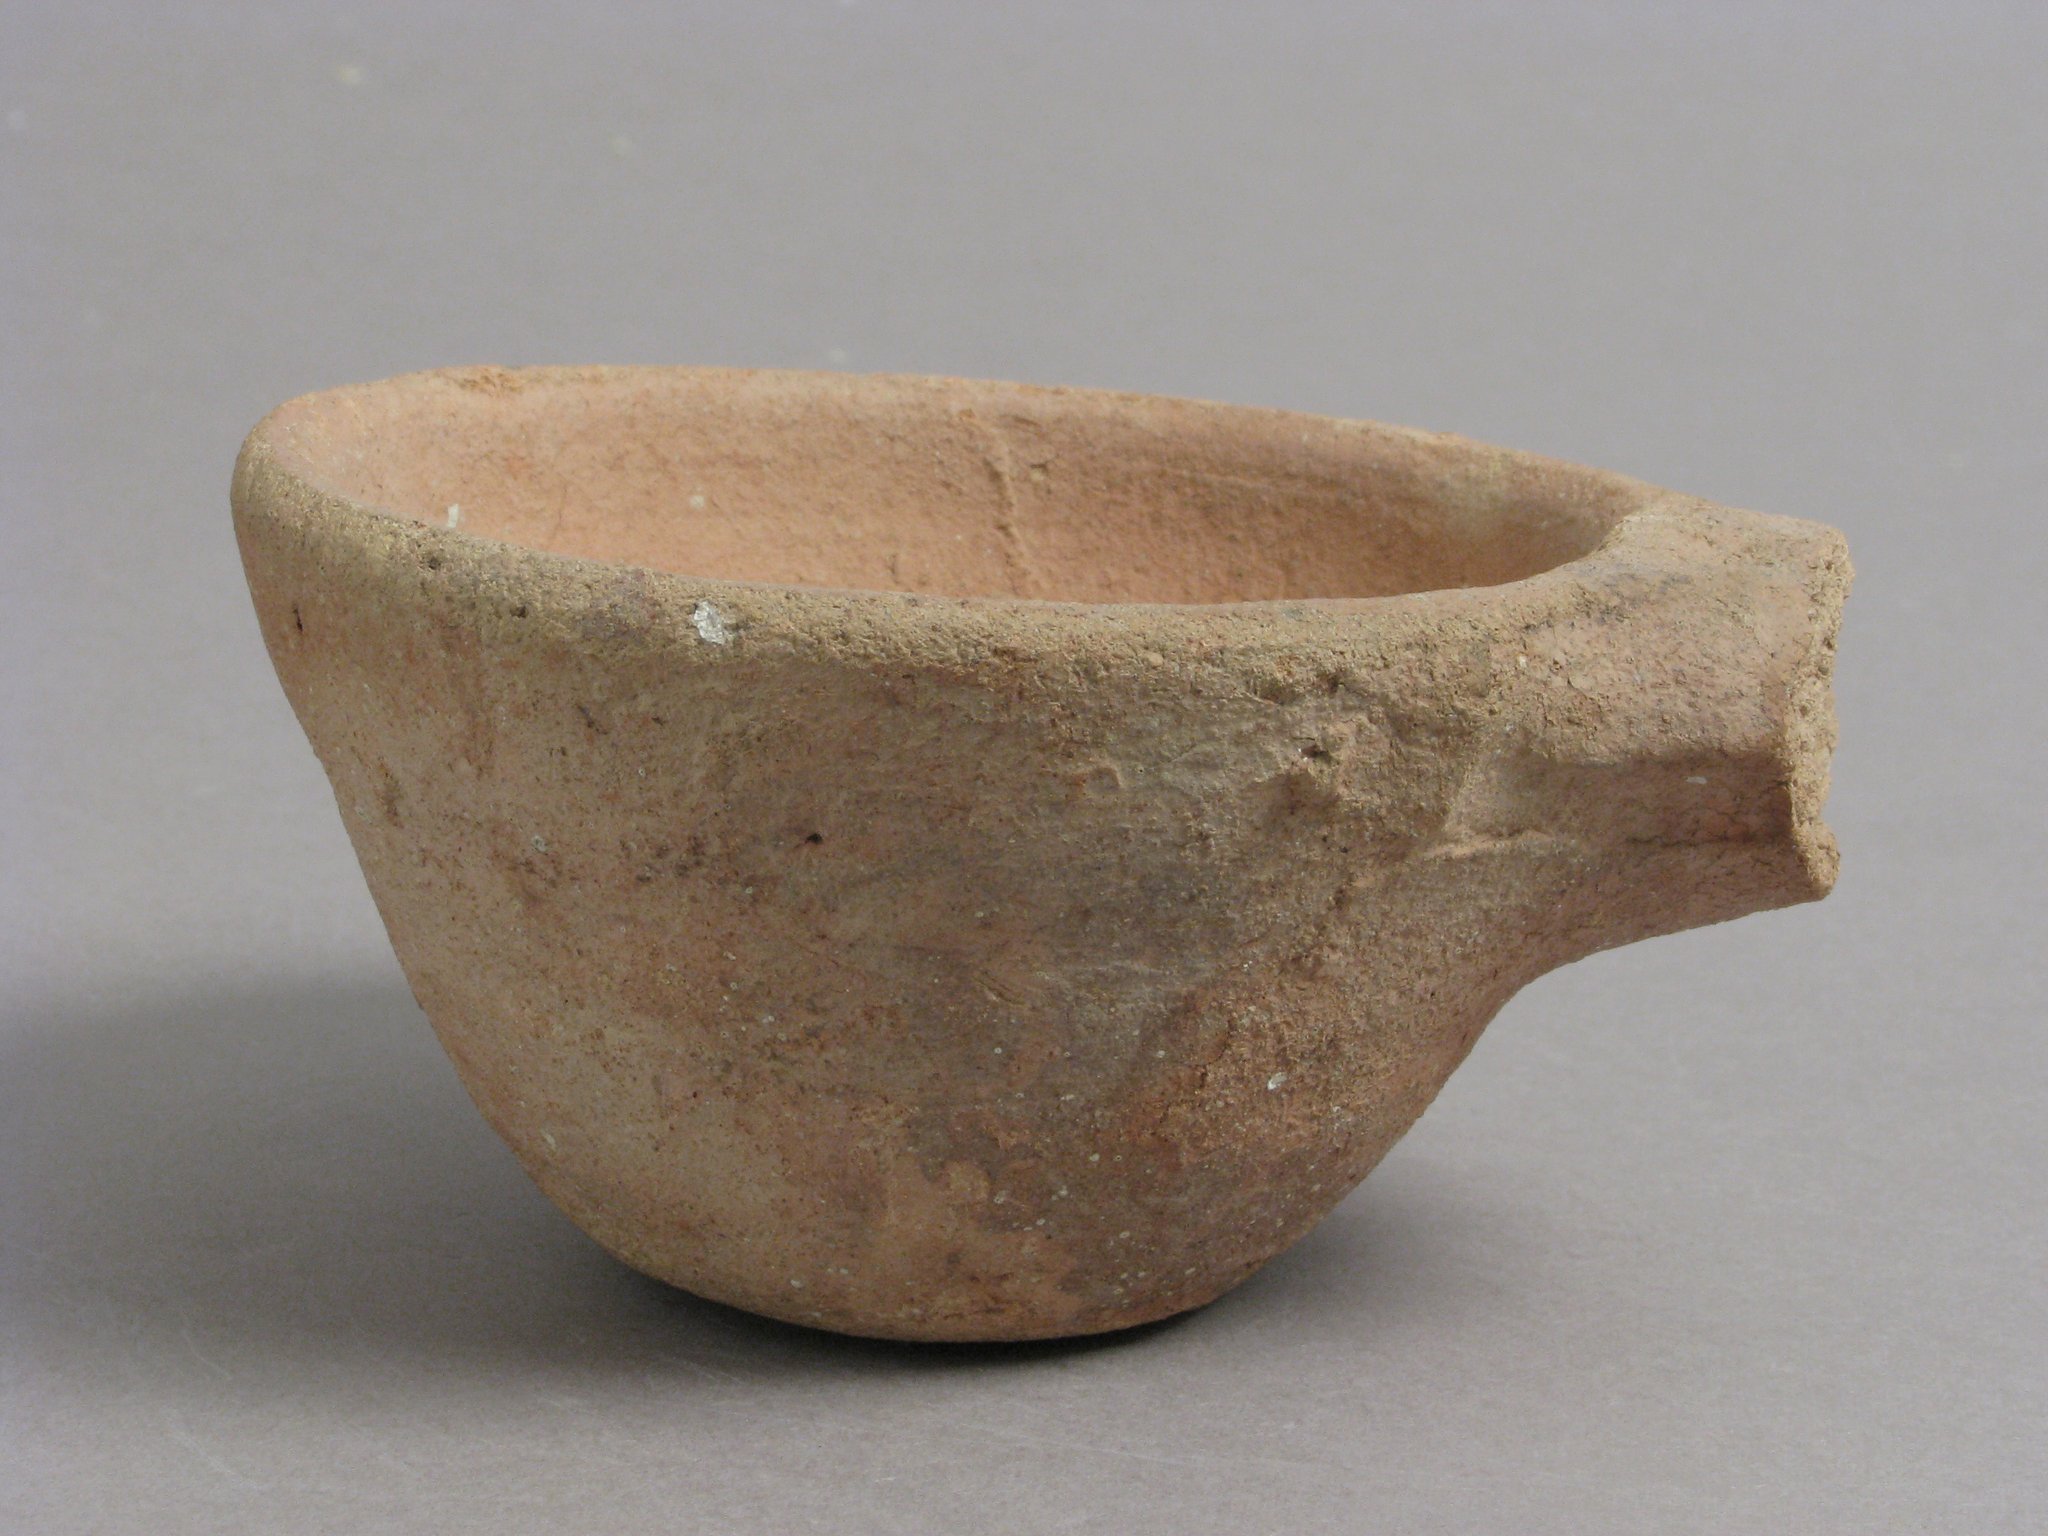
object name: bowl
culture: coptic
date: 301-700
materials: earthenware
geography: egypt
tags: bowls